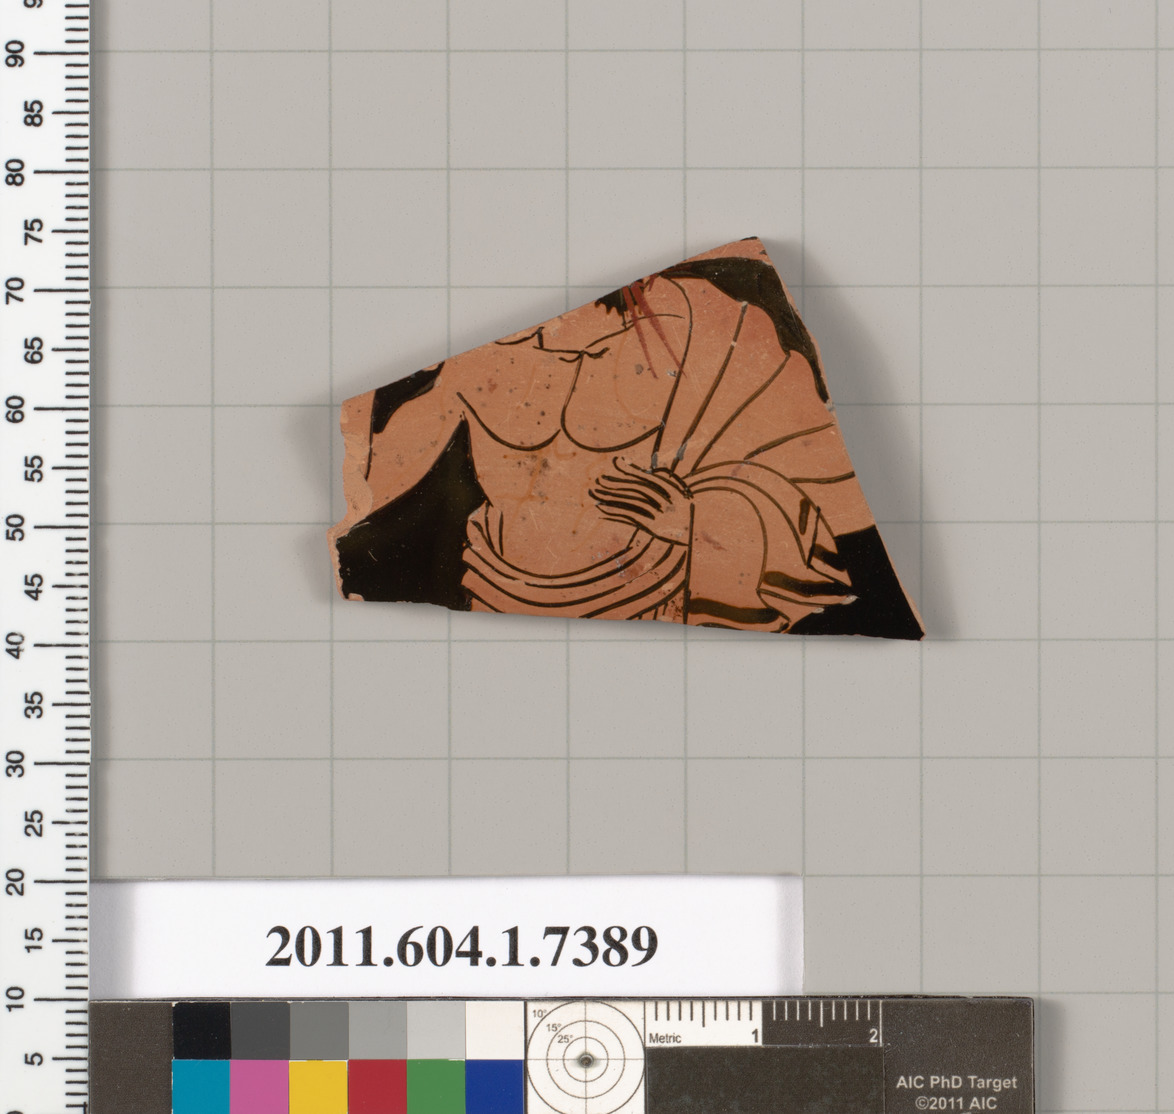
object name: kylix fragment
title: Terracotta fragment of a kylix (drinking cup)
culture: greek, attic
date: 500-480 BCE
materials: terracotta